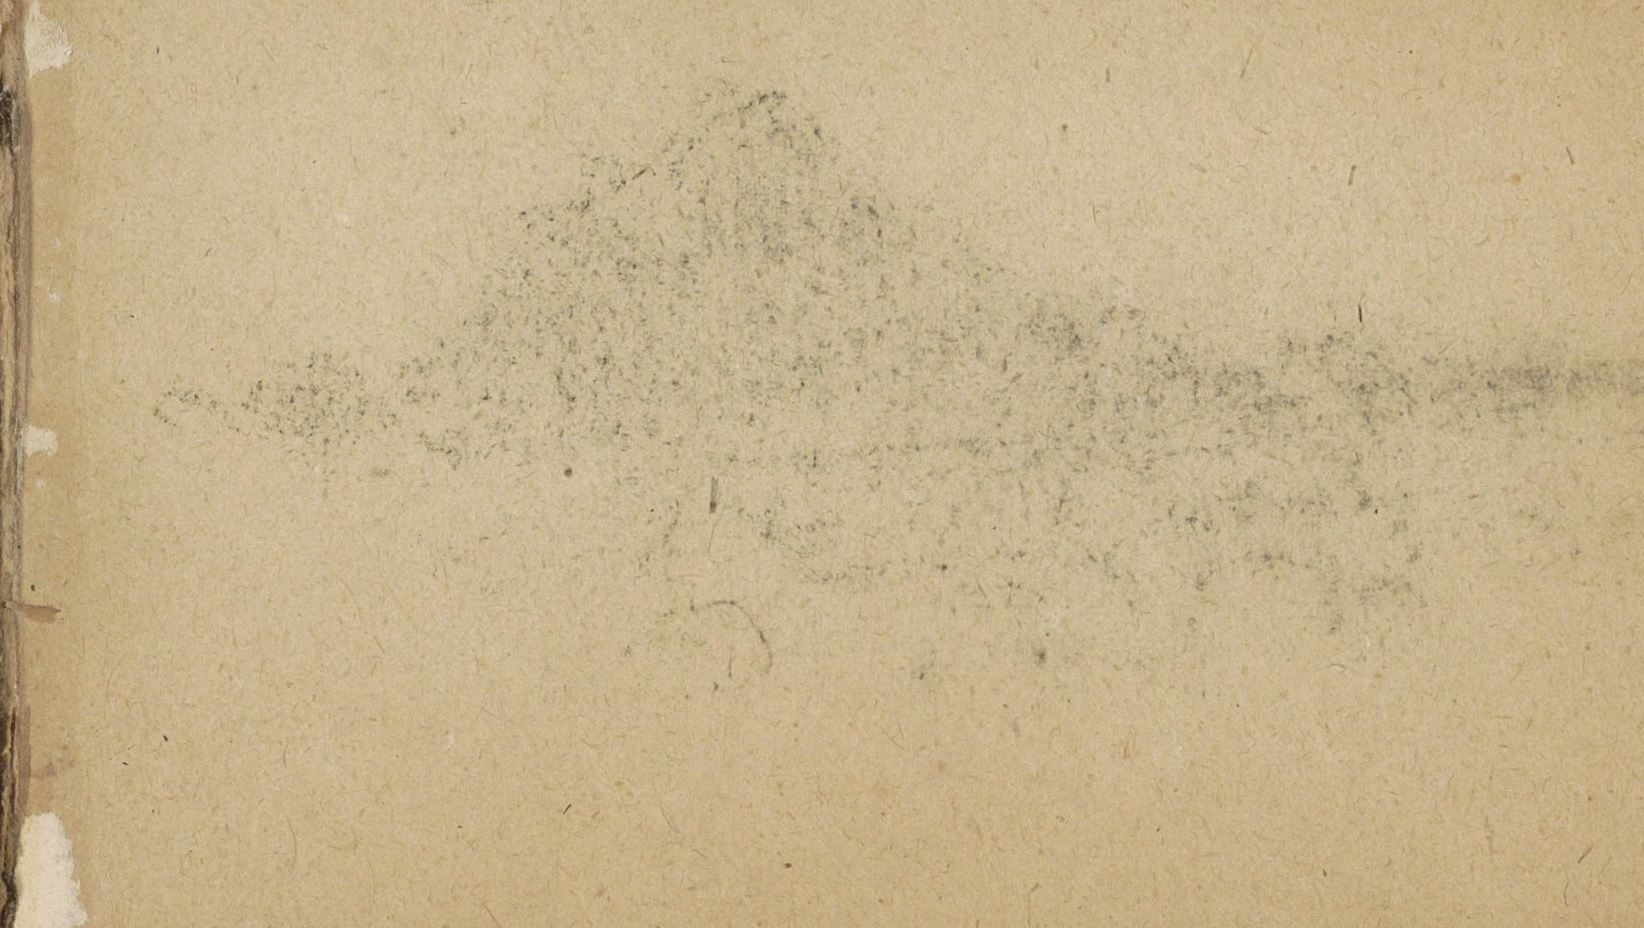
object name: sketchbook leaf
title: Abklatsch van de krijttekening op pagina 32 verso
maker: anton mauve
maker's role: draughtsman, painter, print maker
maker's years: 1838-1888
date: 1876-1879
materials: paper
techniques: printmaking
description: Blad 33 recto uit een schetsboek met 33 bladen.